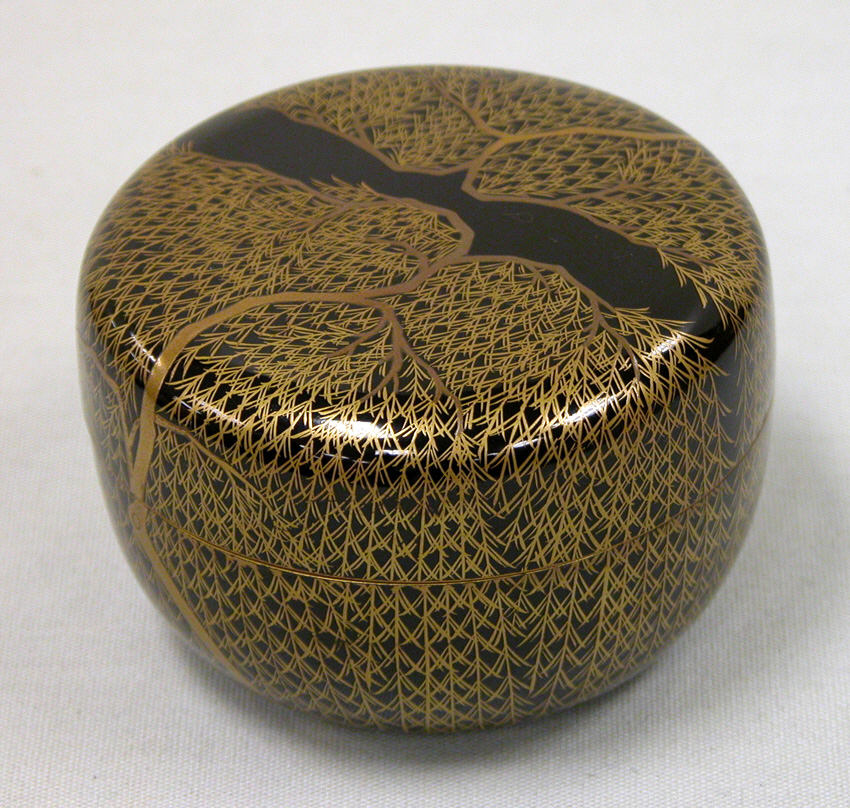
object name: tea caddy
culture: japanese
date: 1767-1800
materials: lacquer